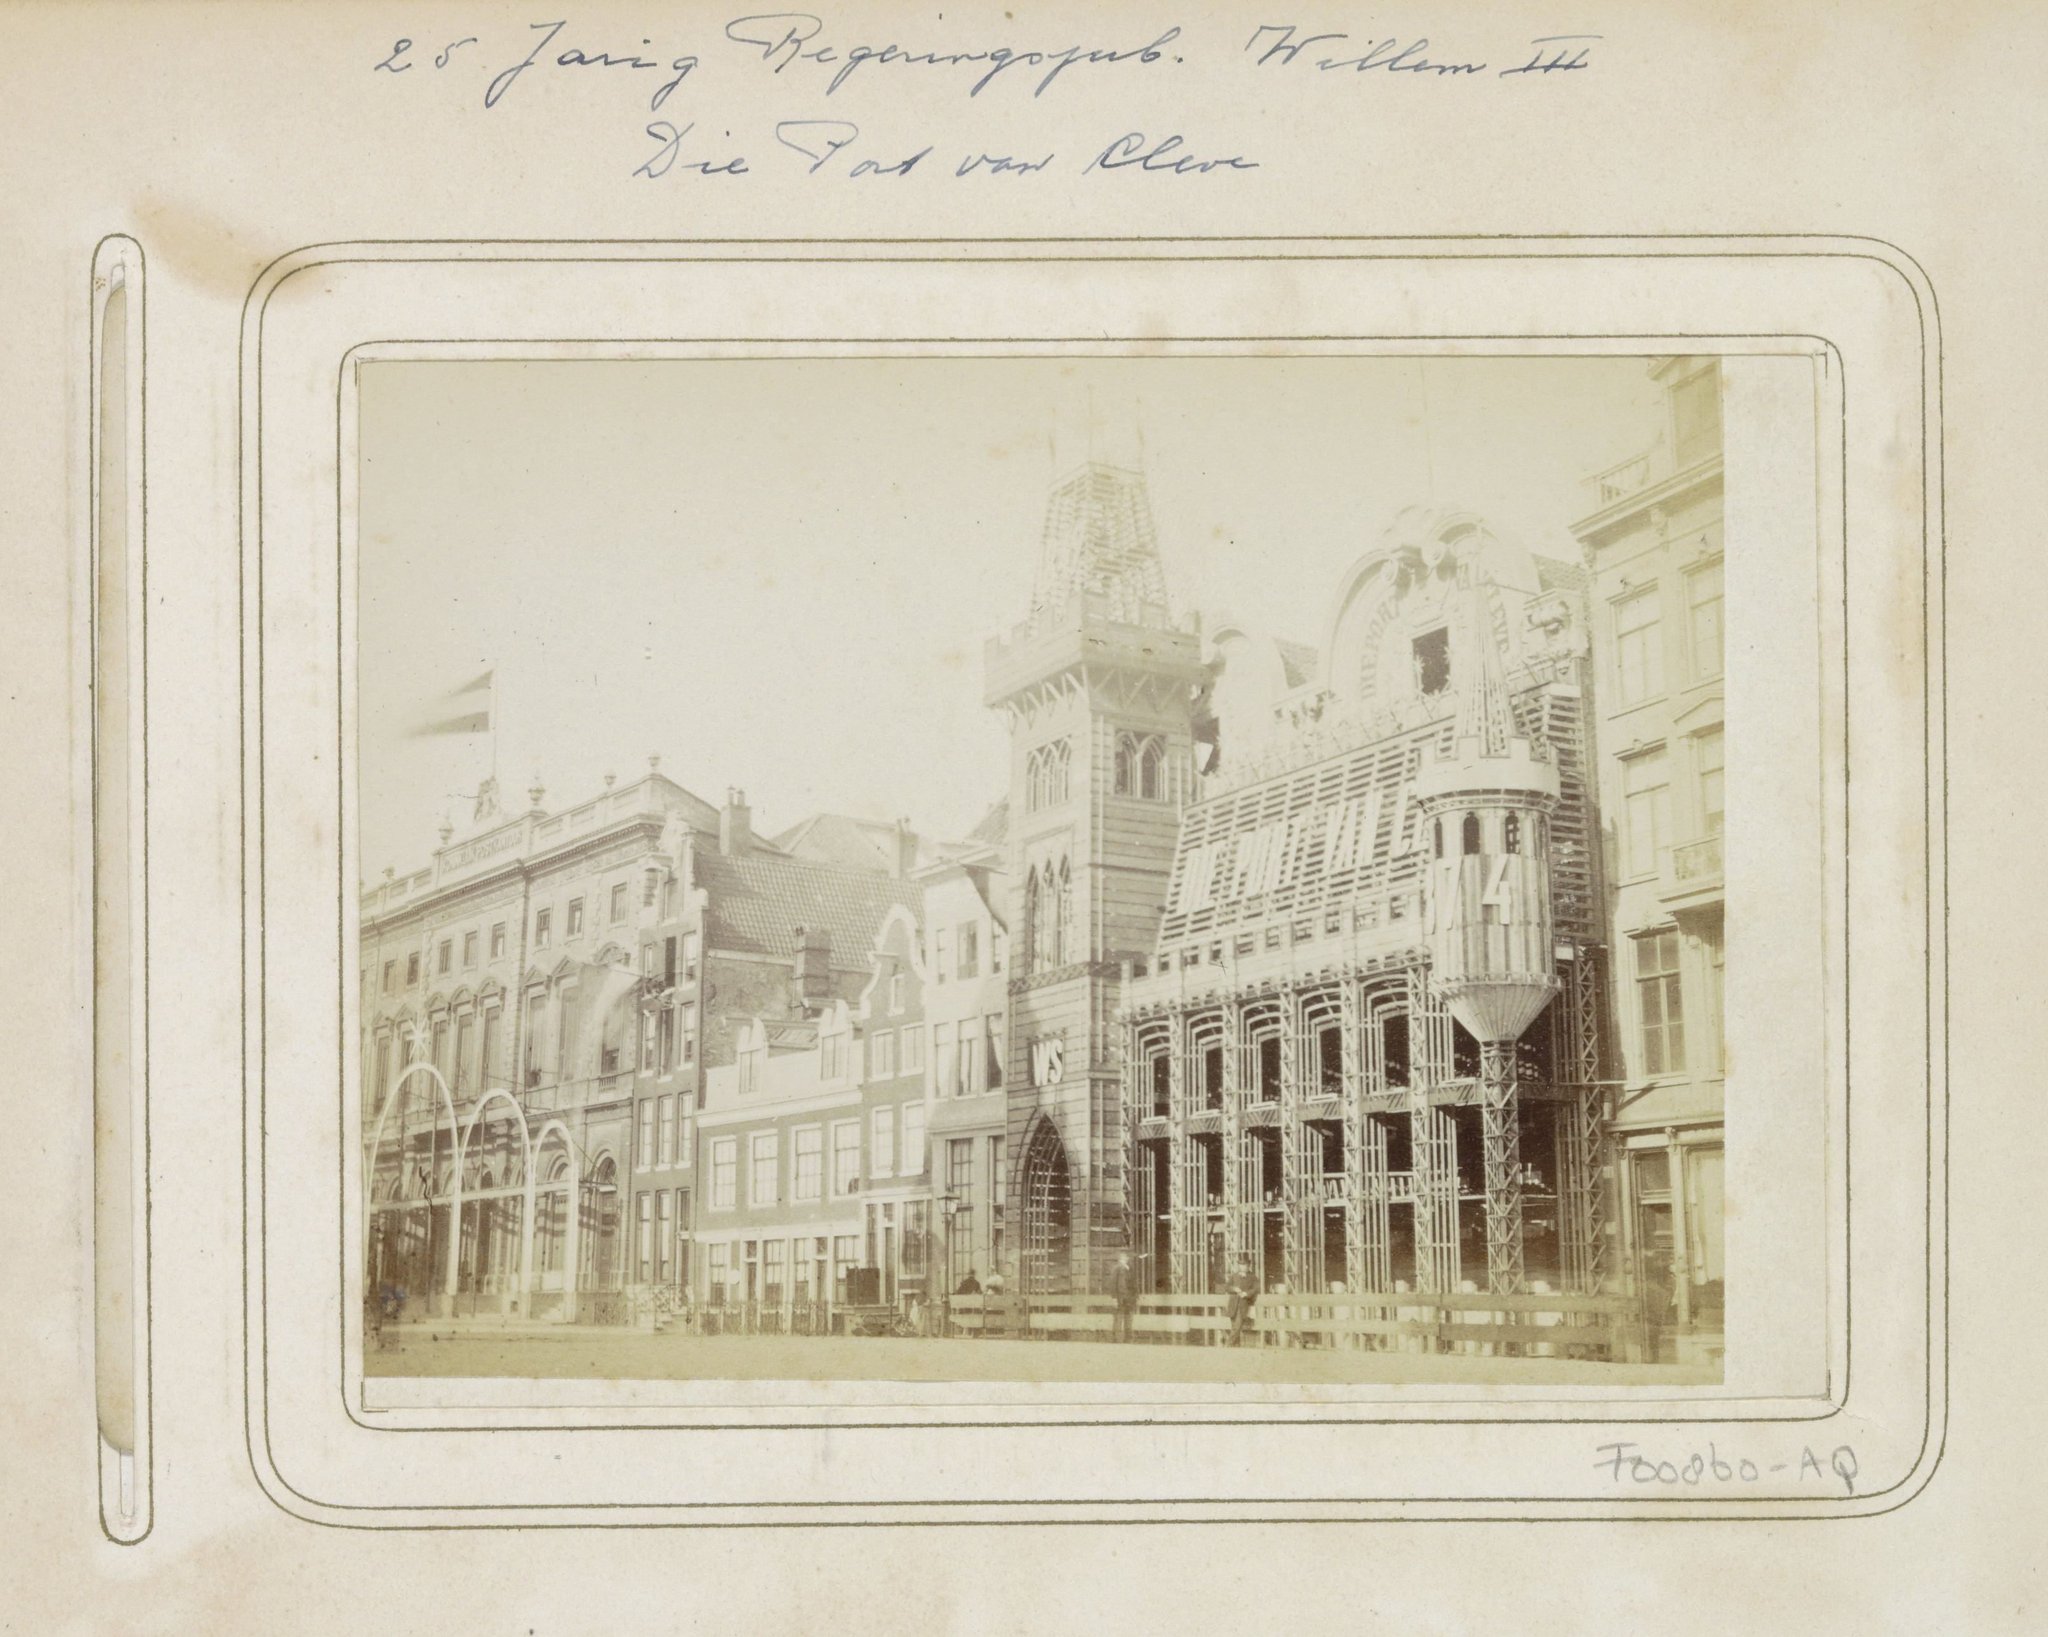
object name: cabinet photograph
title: Koninklijk Postkantoor (links) en restaurant-bierhuis Die Port van Cleve (rechts) aan de Nieuwezijds Voorburgwal, versierd ter gelegenheid van het 25-jarig regeringsjubileum van koning Willem III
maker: Anonymous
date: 1874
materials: cardboard, paper, photographic support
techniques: albumen print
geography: amsterdam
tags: public festivities on the occasion of royal events, post-office, commemoration, jubilee (+ the public ~ festive activities), inn, coffee-house, public house, etc., restaurant, prospect of city, town panorama, silhouette of city, amsterdam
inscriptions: inscription: ‘Amsterdam. Port van Cleve en Postkantoor. N.Z. Voorburgwal 25 jarig regeeringsjubileüm Willem III’